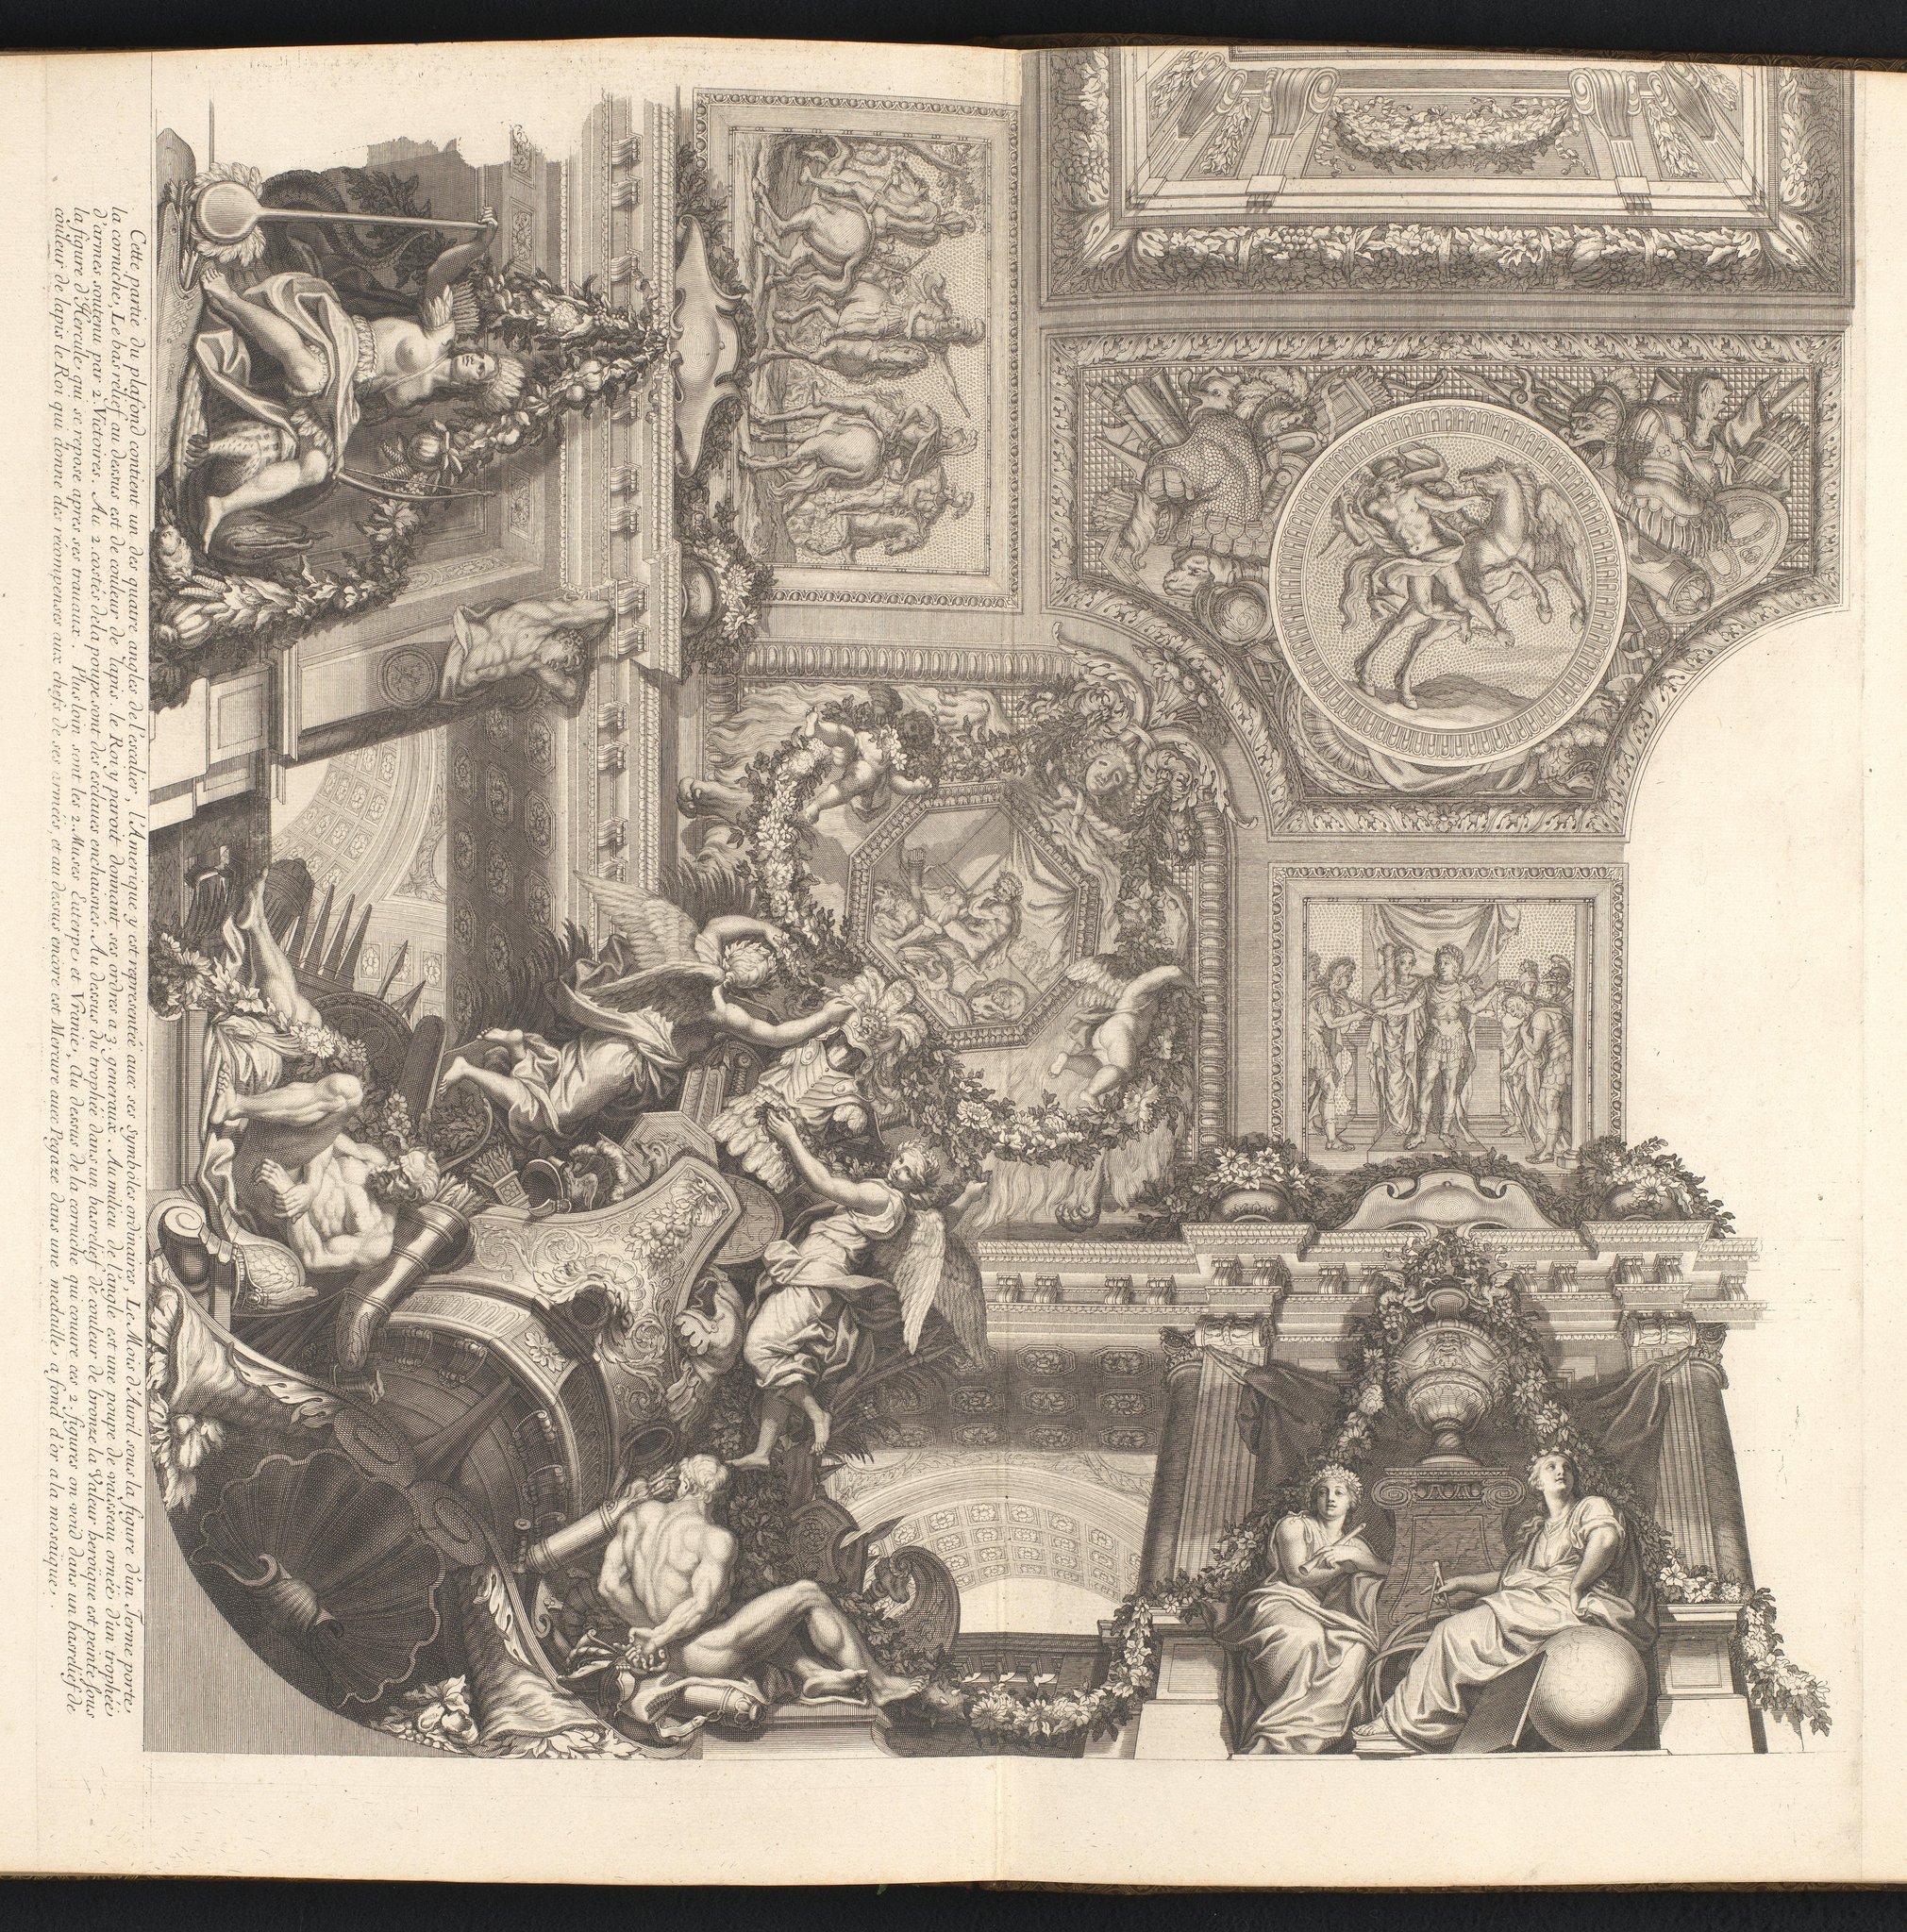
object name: album leaf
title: Grand Escalier du Chateau de Versailles dit Escalier des Ambassadeurs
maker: etienne baudet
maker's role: print maker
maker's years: 1638-1711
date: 1648-1711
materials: paper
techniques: engraving, etching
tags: ornaments ~ art, america represented allegorically; 'america' (ripa), (decorated) ceiling, urania (one of the muses); 'urania' (ripa), euterpe (one of the muses); 'euterpe' (ripa)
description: Met onder andere een personificatie van Amerika, Urania en Euterpe. Deze prent maakt deel uit van een album.